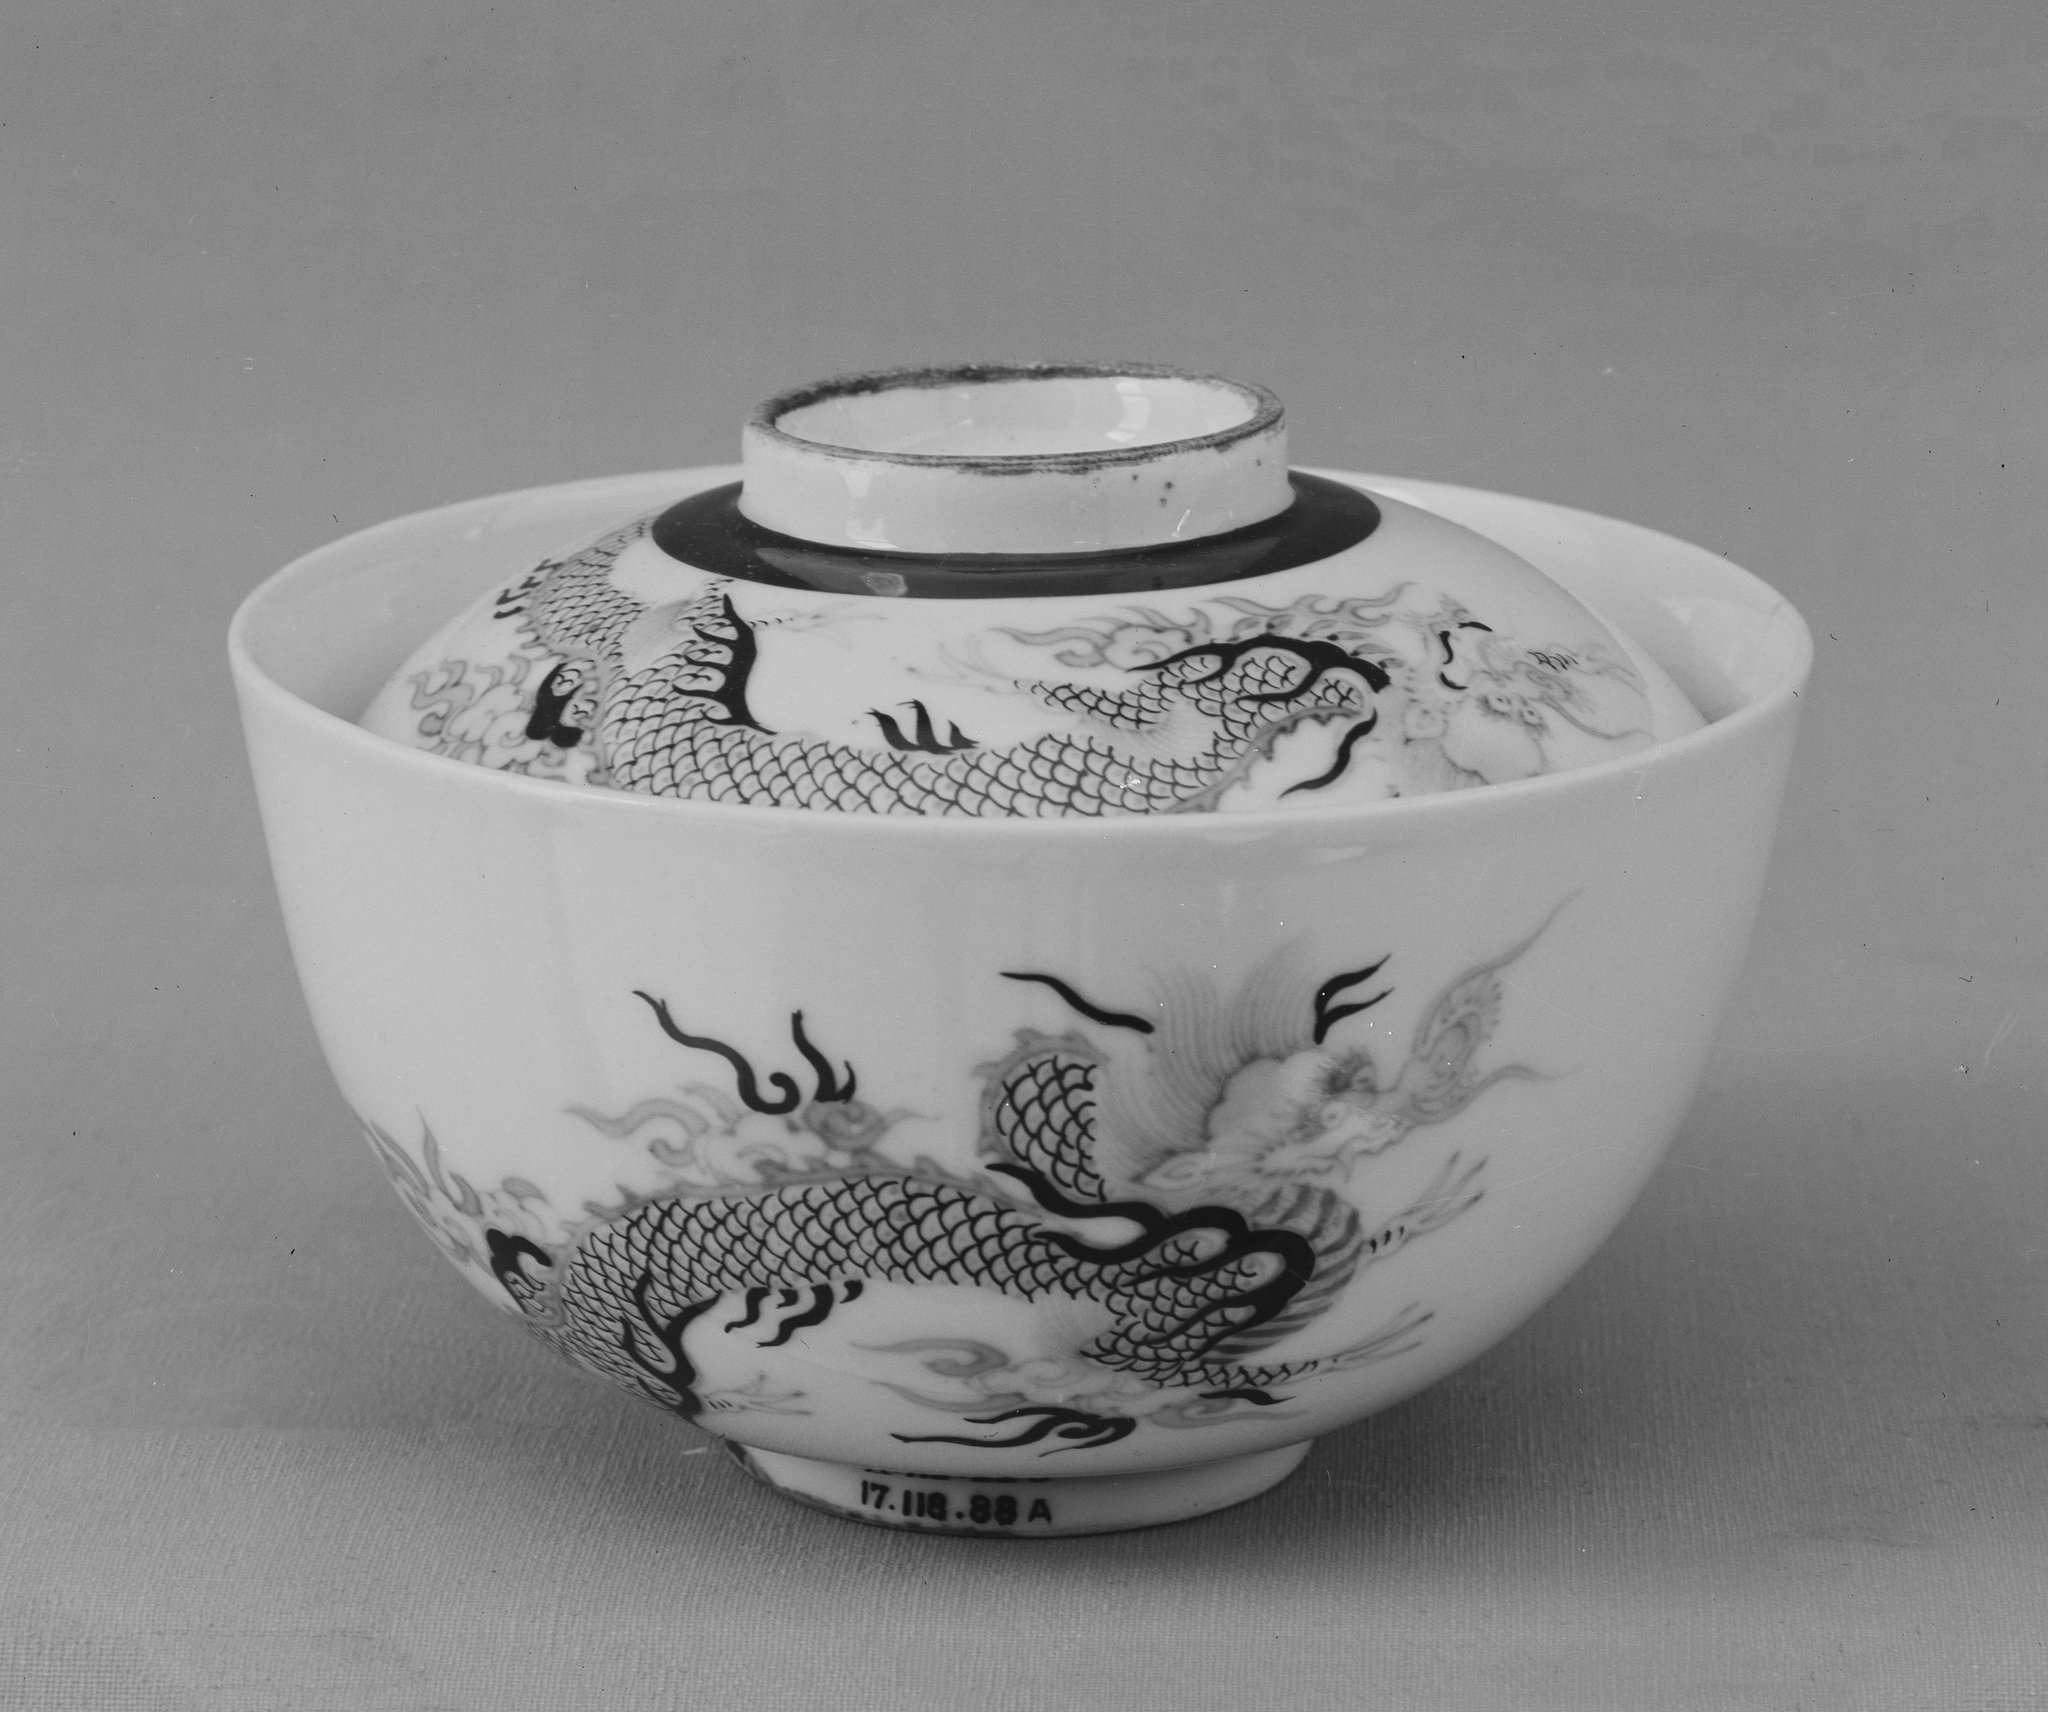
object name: bowl with cover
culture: japanese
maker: kakiemon i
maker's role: artist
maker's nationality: japanese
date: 1675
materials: glaze, iron, porcelain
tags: dragons